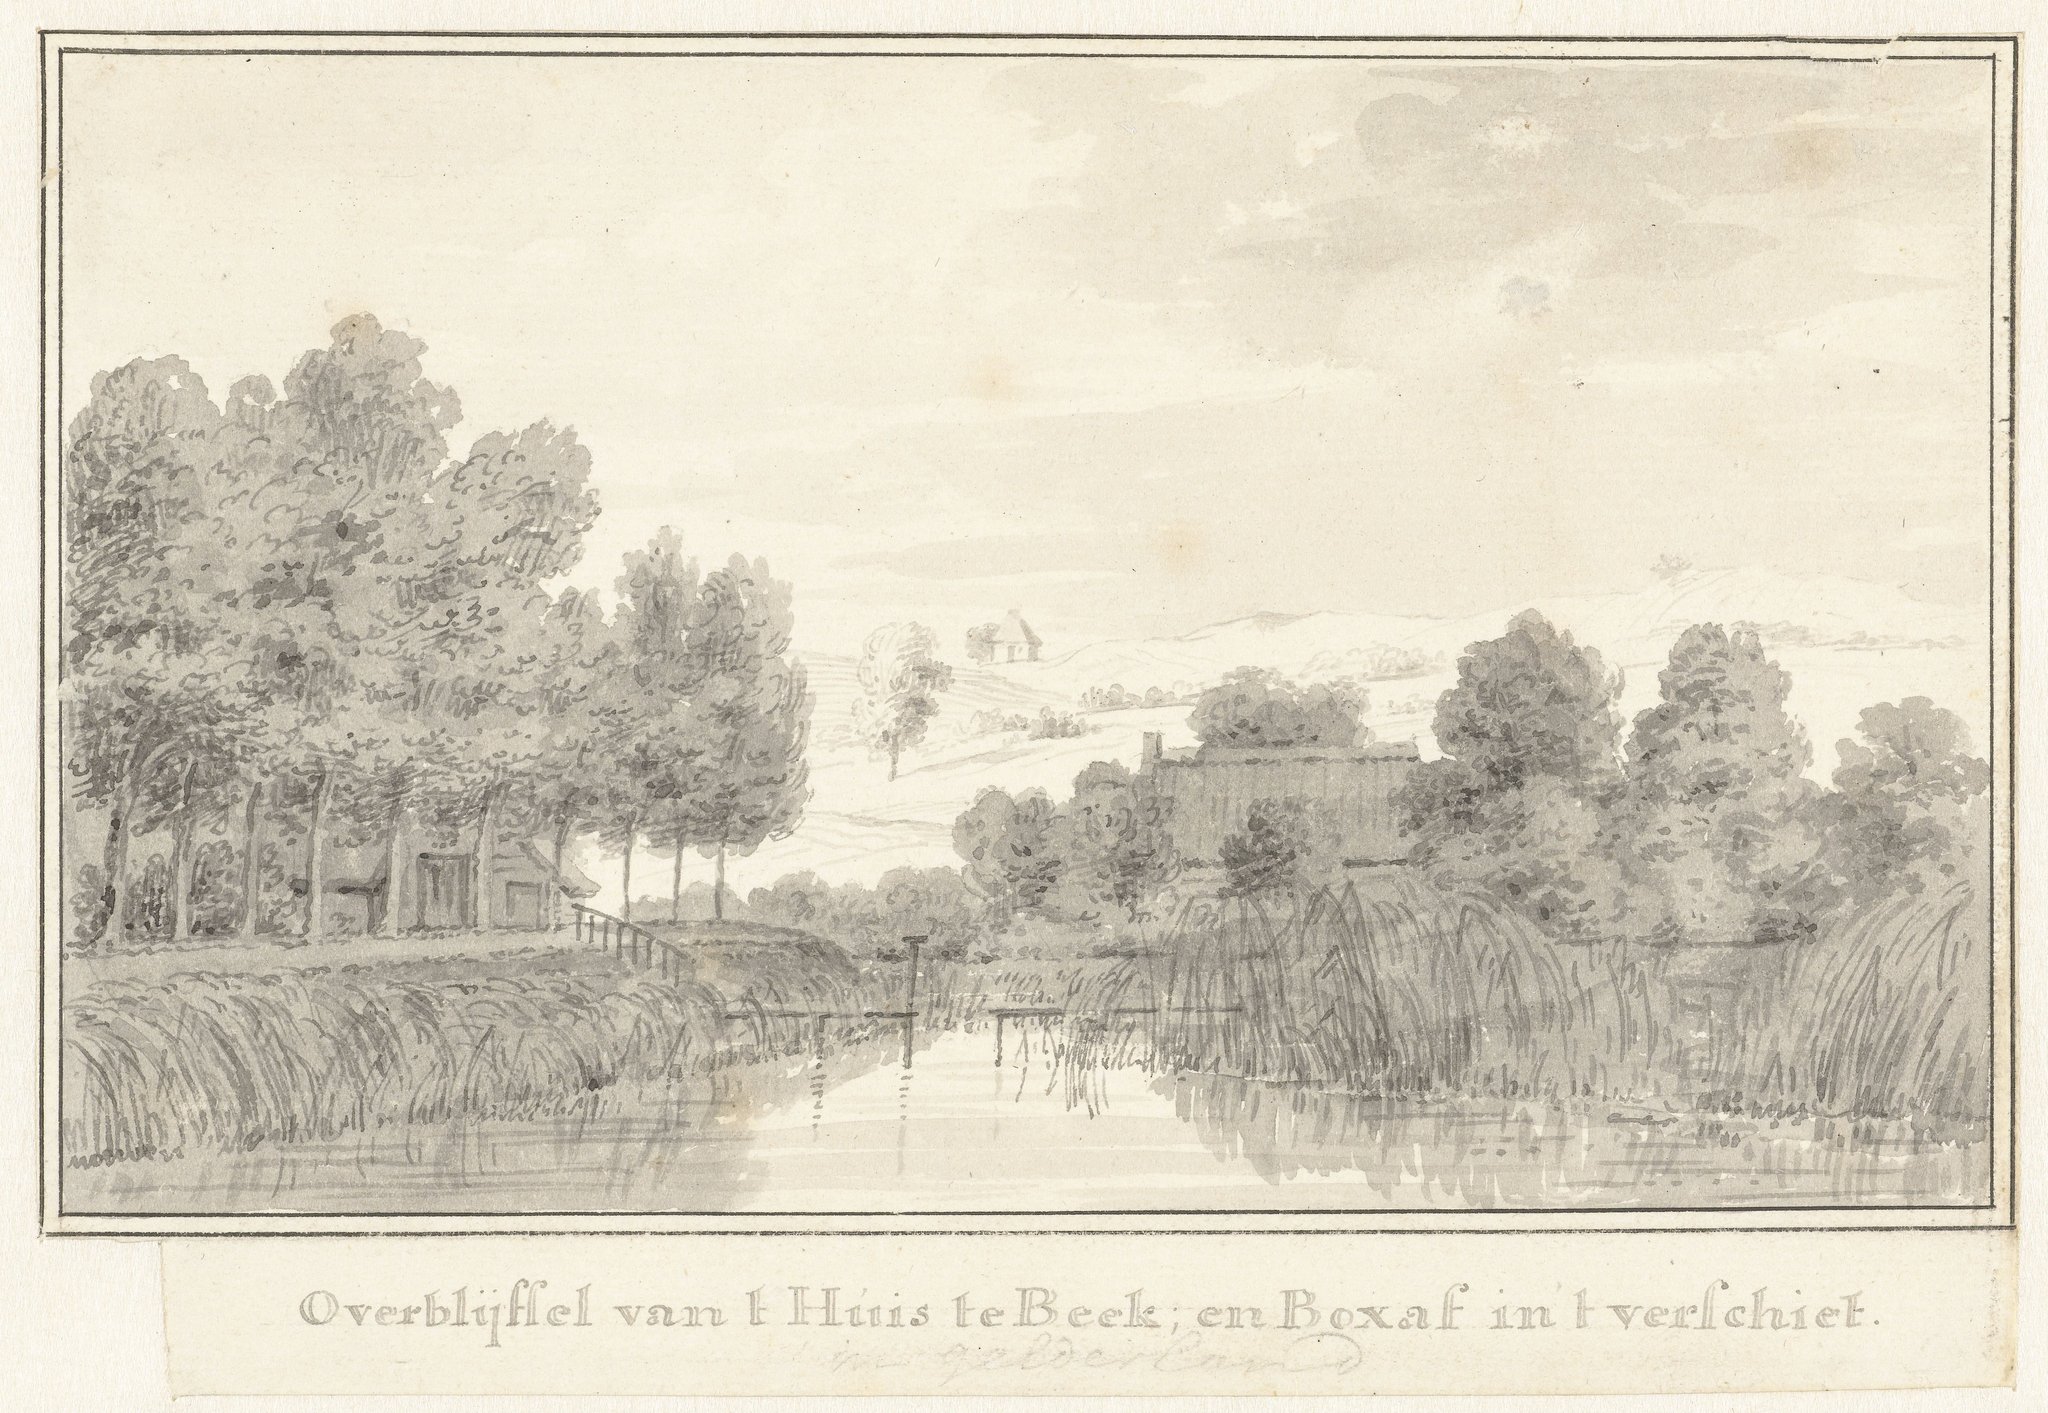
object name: drawing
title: Overblijfselen van het Huis ter Beek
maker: cornelis pronk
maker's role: draughtsman, painter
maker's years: 1691-1759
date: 1701-1759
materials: ink, paper, pencil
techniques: brush, pen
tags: castle, ruin of a building ~ architecture